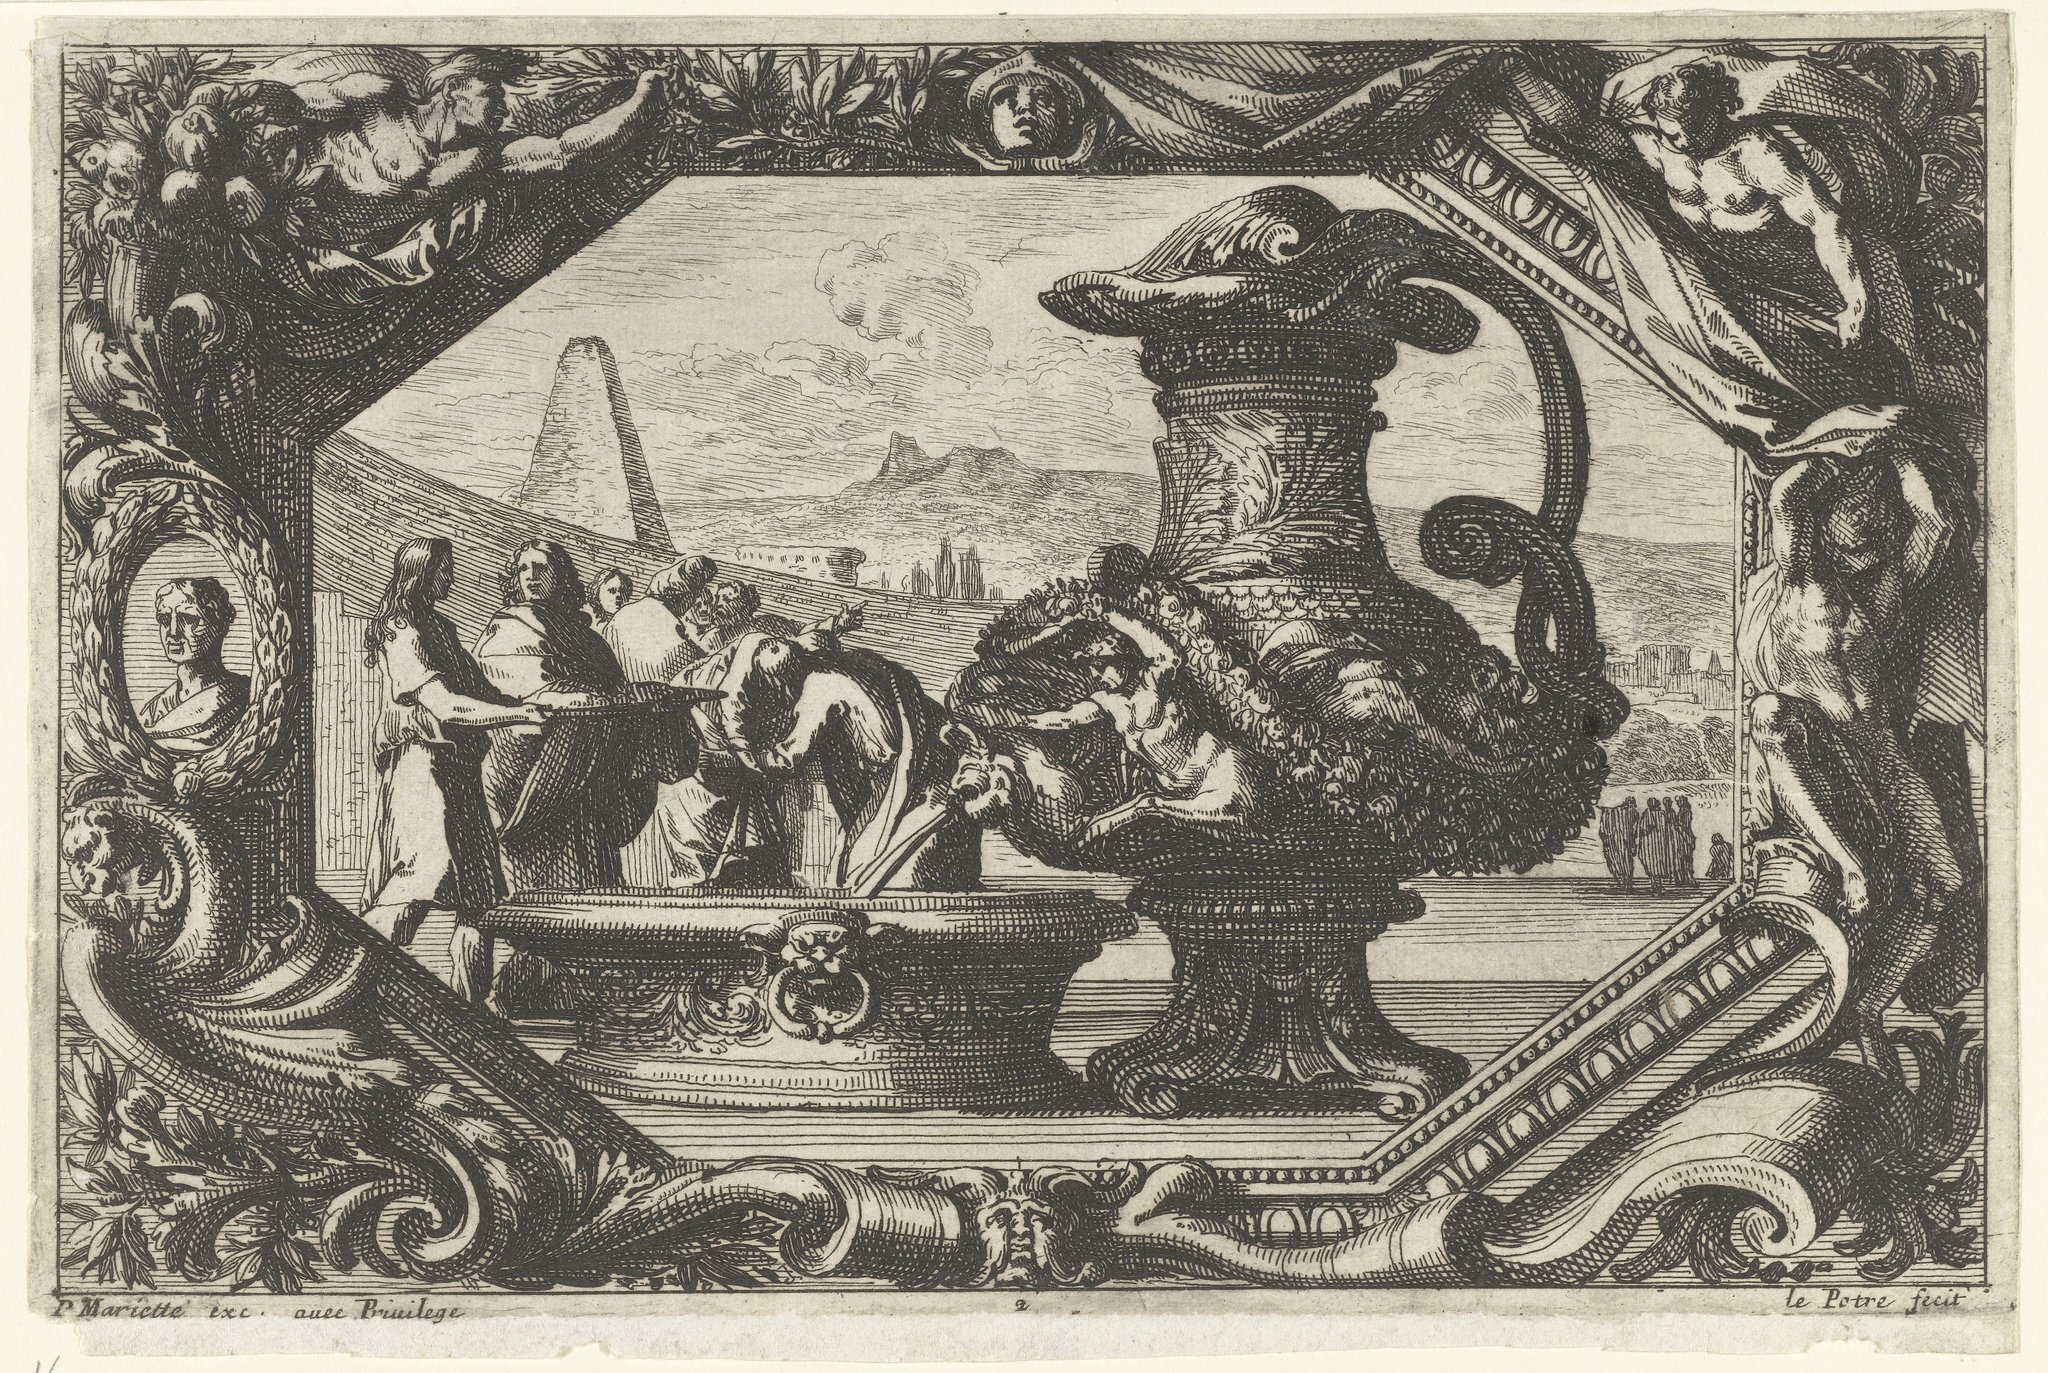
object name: ornament print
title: Bassin en mobiele waterfontein in cartouche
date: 1657-1661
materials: paper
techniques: etching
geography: paris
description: Op de achtergrond is een landschap met een piramide te zien. Uit derde editie.